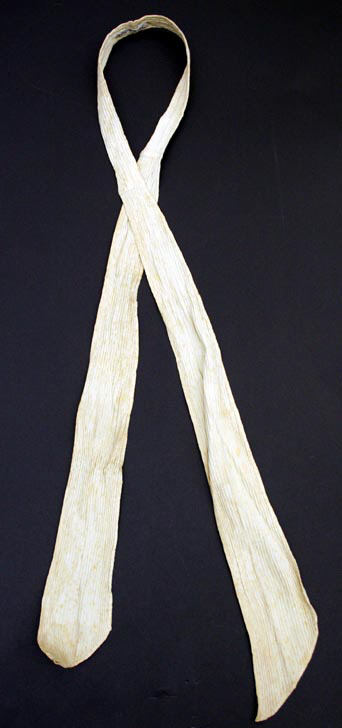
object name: neckcloth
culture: european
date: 1830-1839